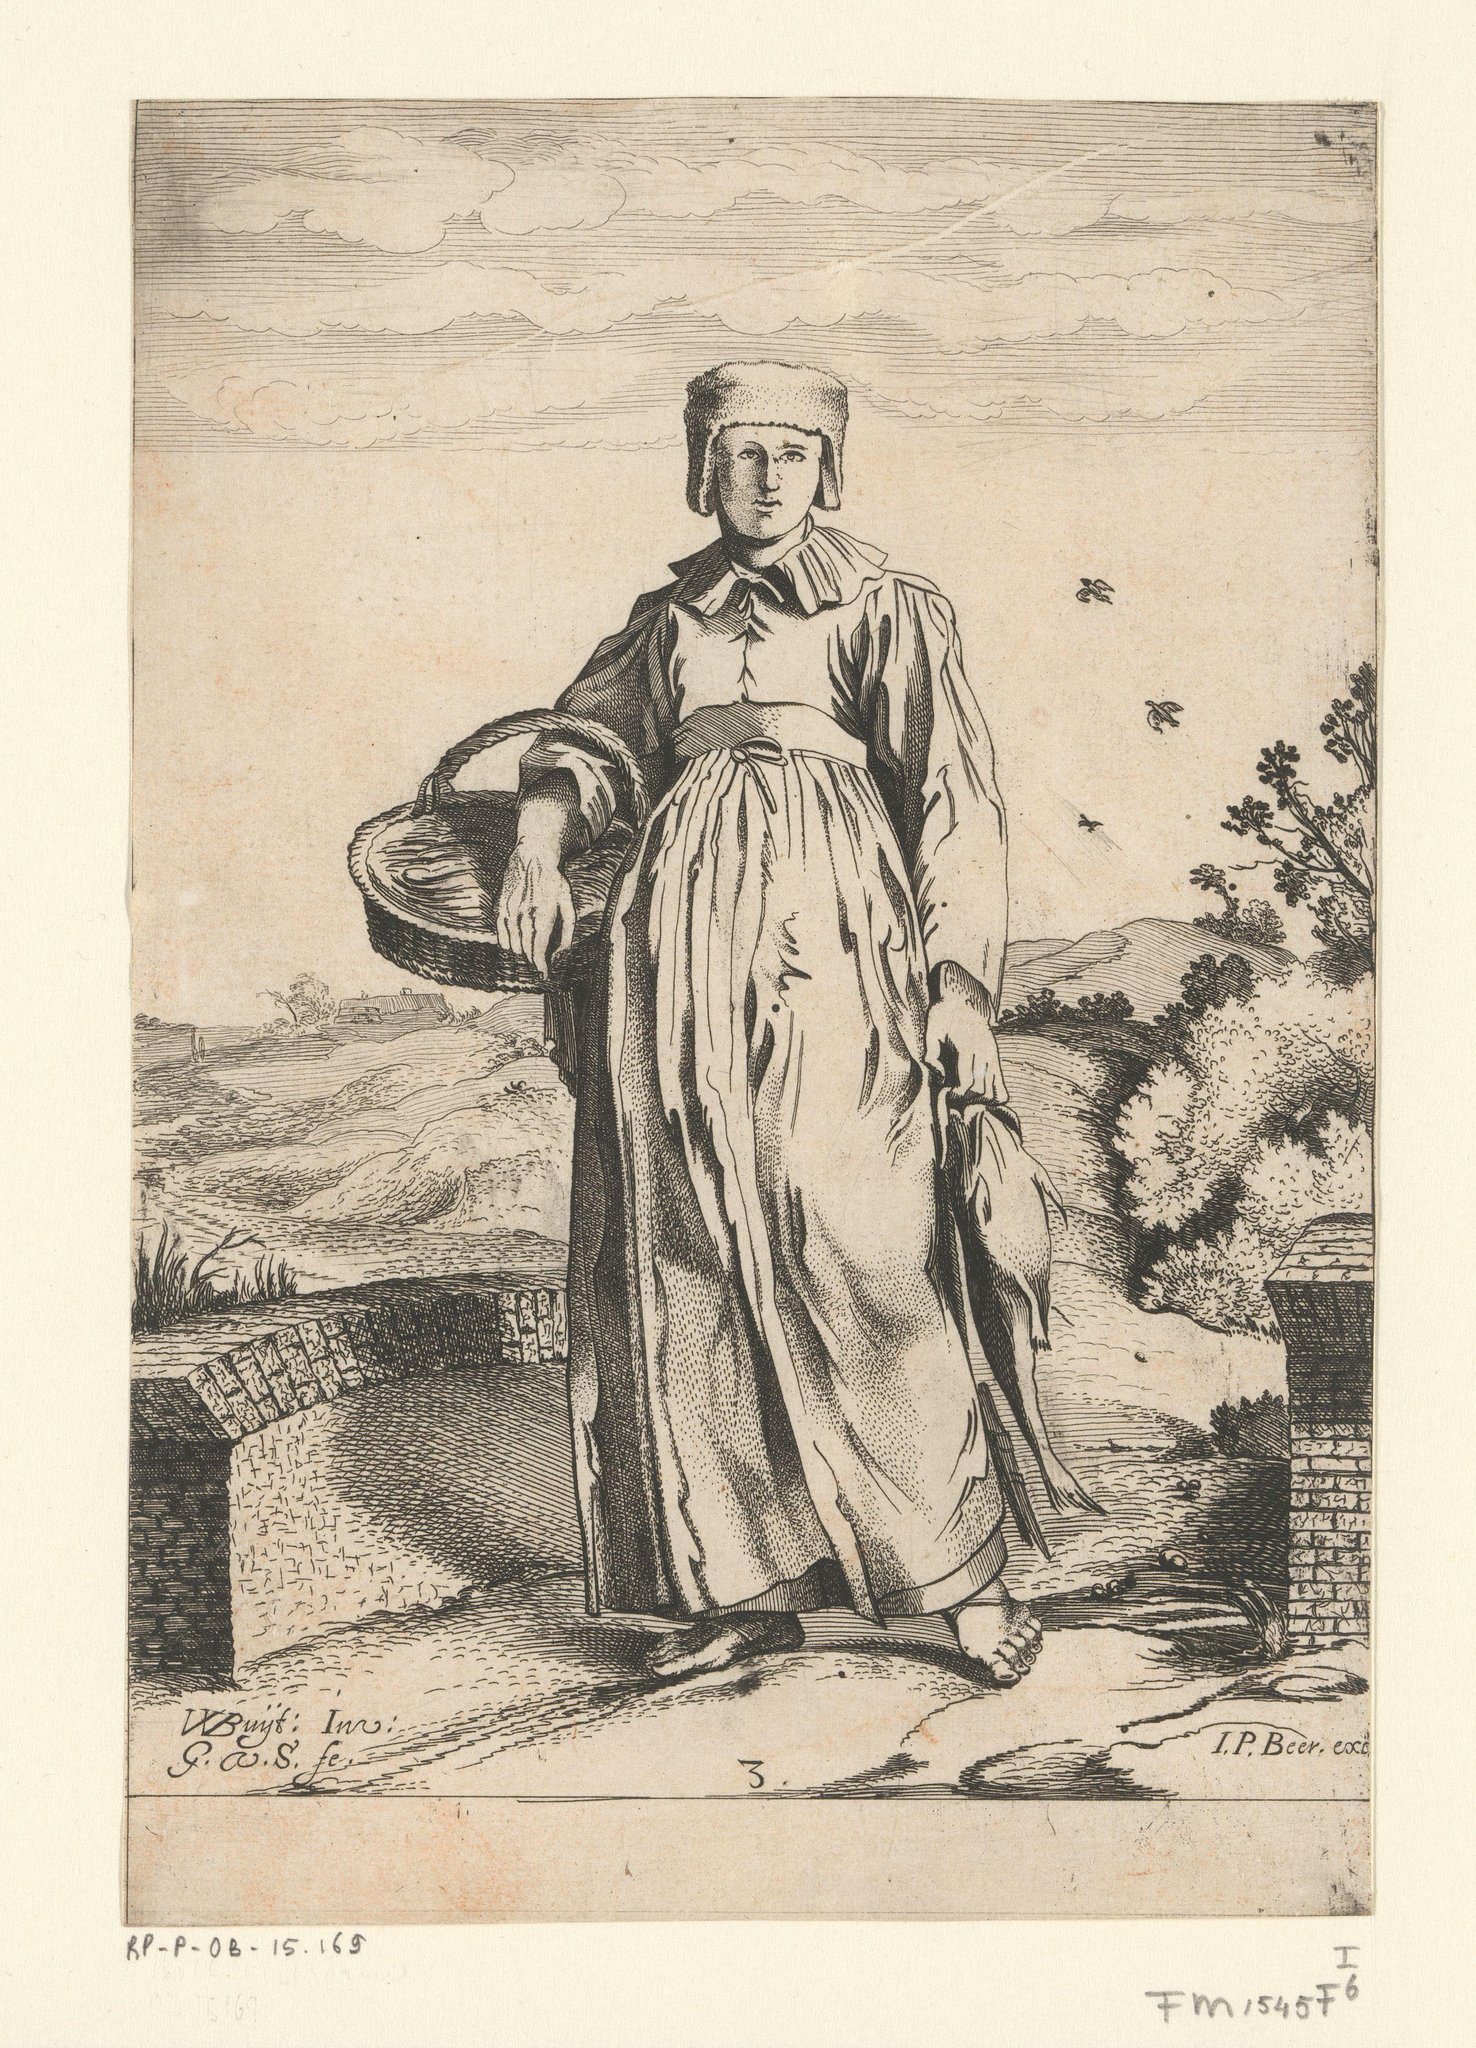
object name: print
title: Noord-Hollandse klederdrachten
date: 1620-1624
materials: paper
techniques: etching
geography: haarlem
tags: folk costume, regional costume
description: In een duinlandschap staat een jonge vrouw uit een vissersdorp aan de Noordzeekust, gekleed in klederdracht. Om de arm heeft ze een mand en in de hand een vis. De prent maakt deel uit van een serie van acht jonge vrouwen in Noord-Hollandse klederdrachten.